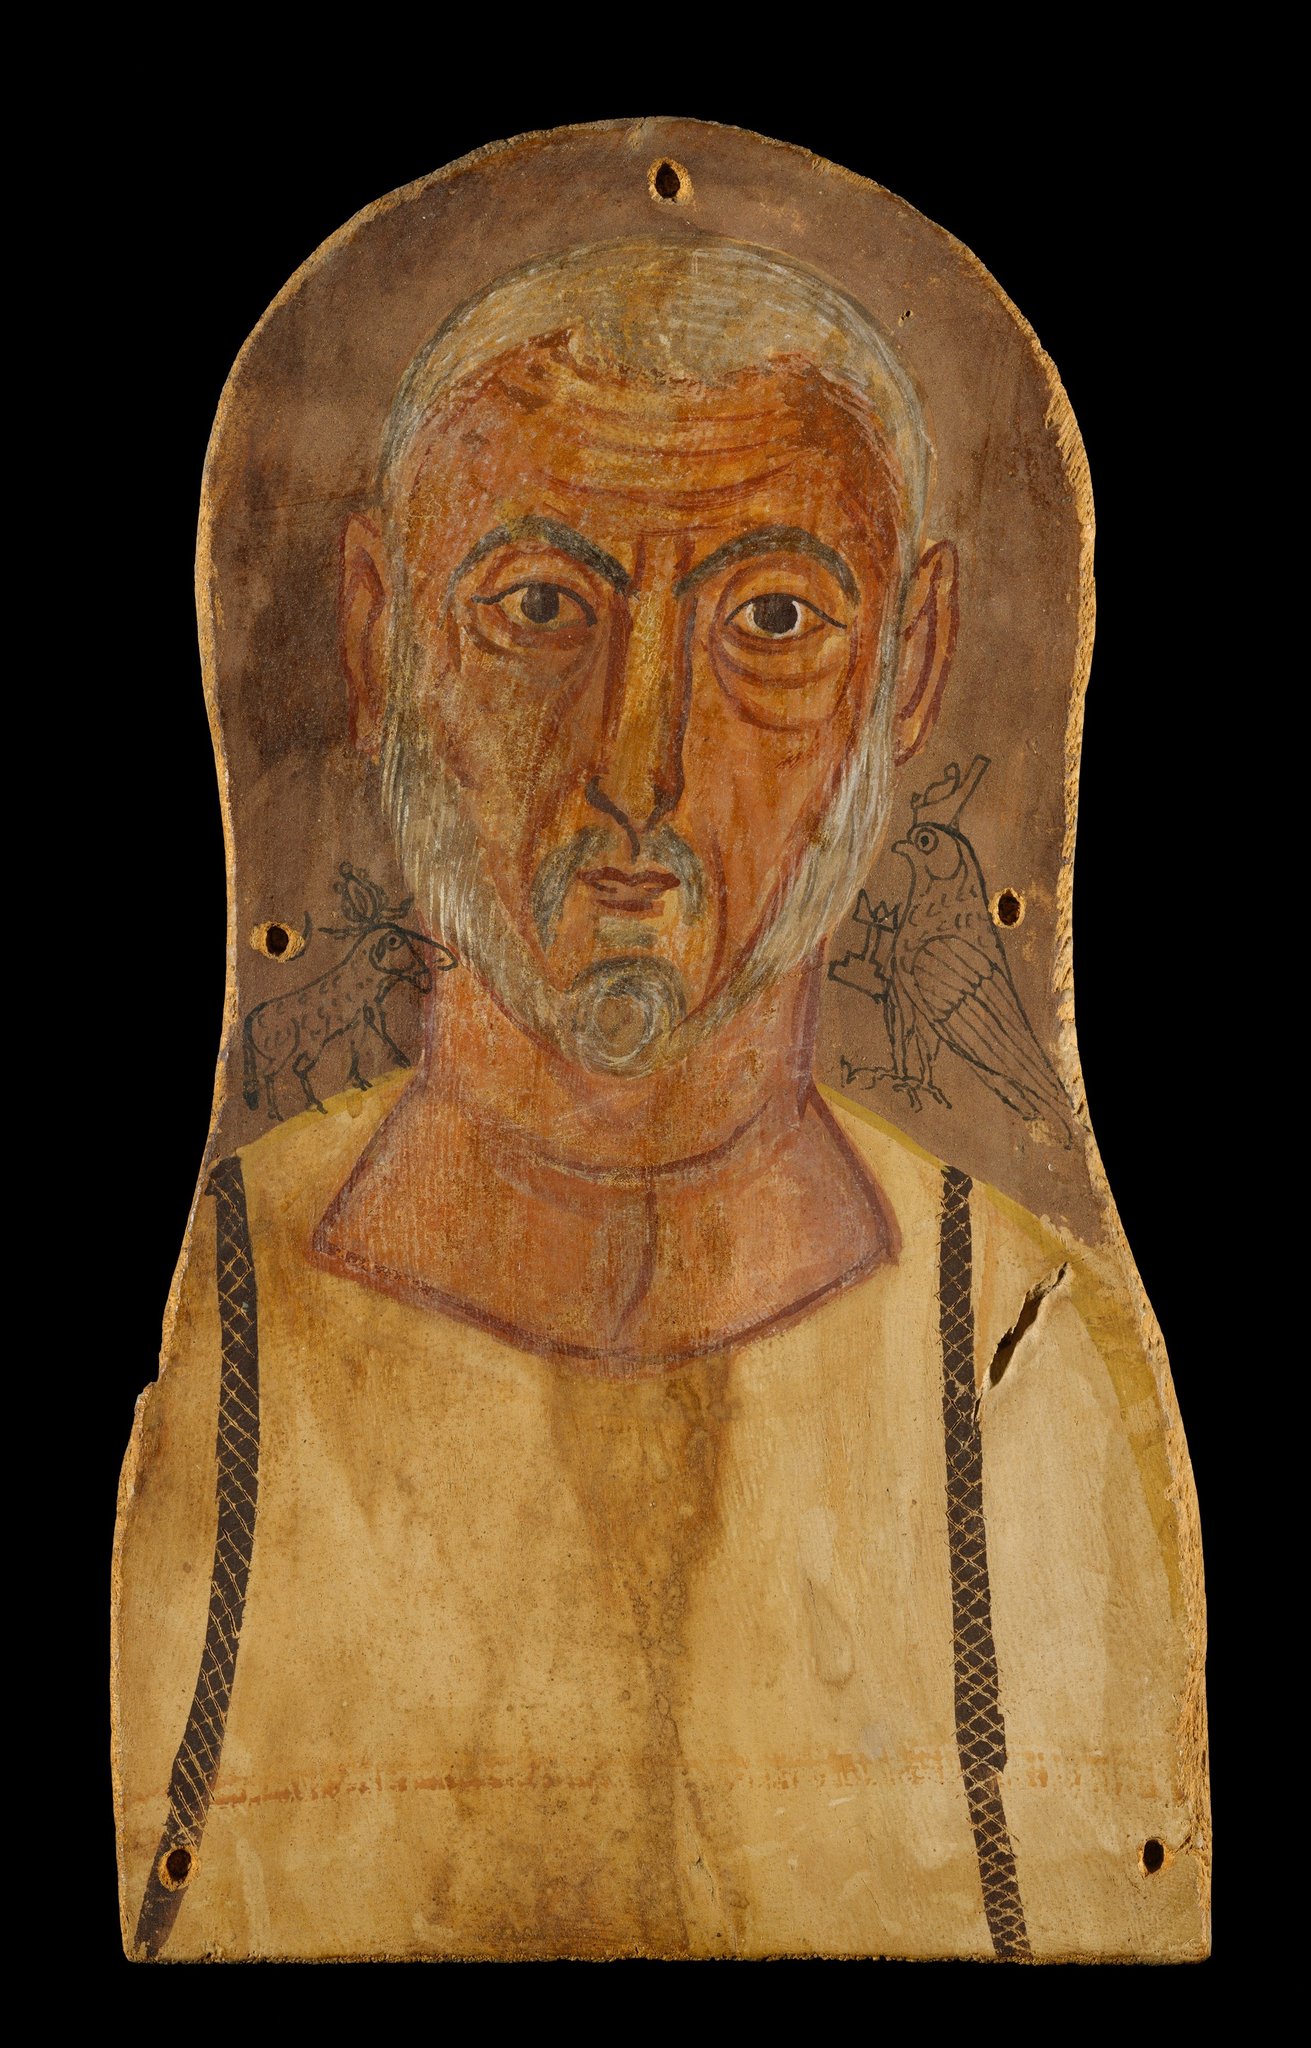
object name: panel painting, elderly man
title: Elderly Man Flanked by Egyptian Gods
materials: paint, wood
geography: egypt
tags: falcons,men,portraits,horus,rams